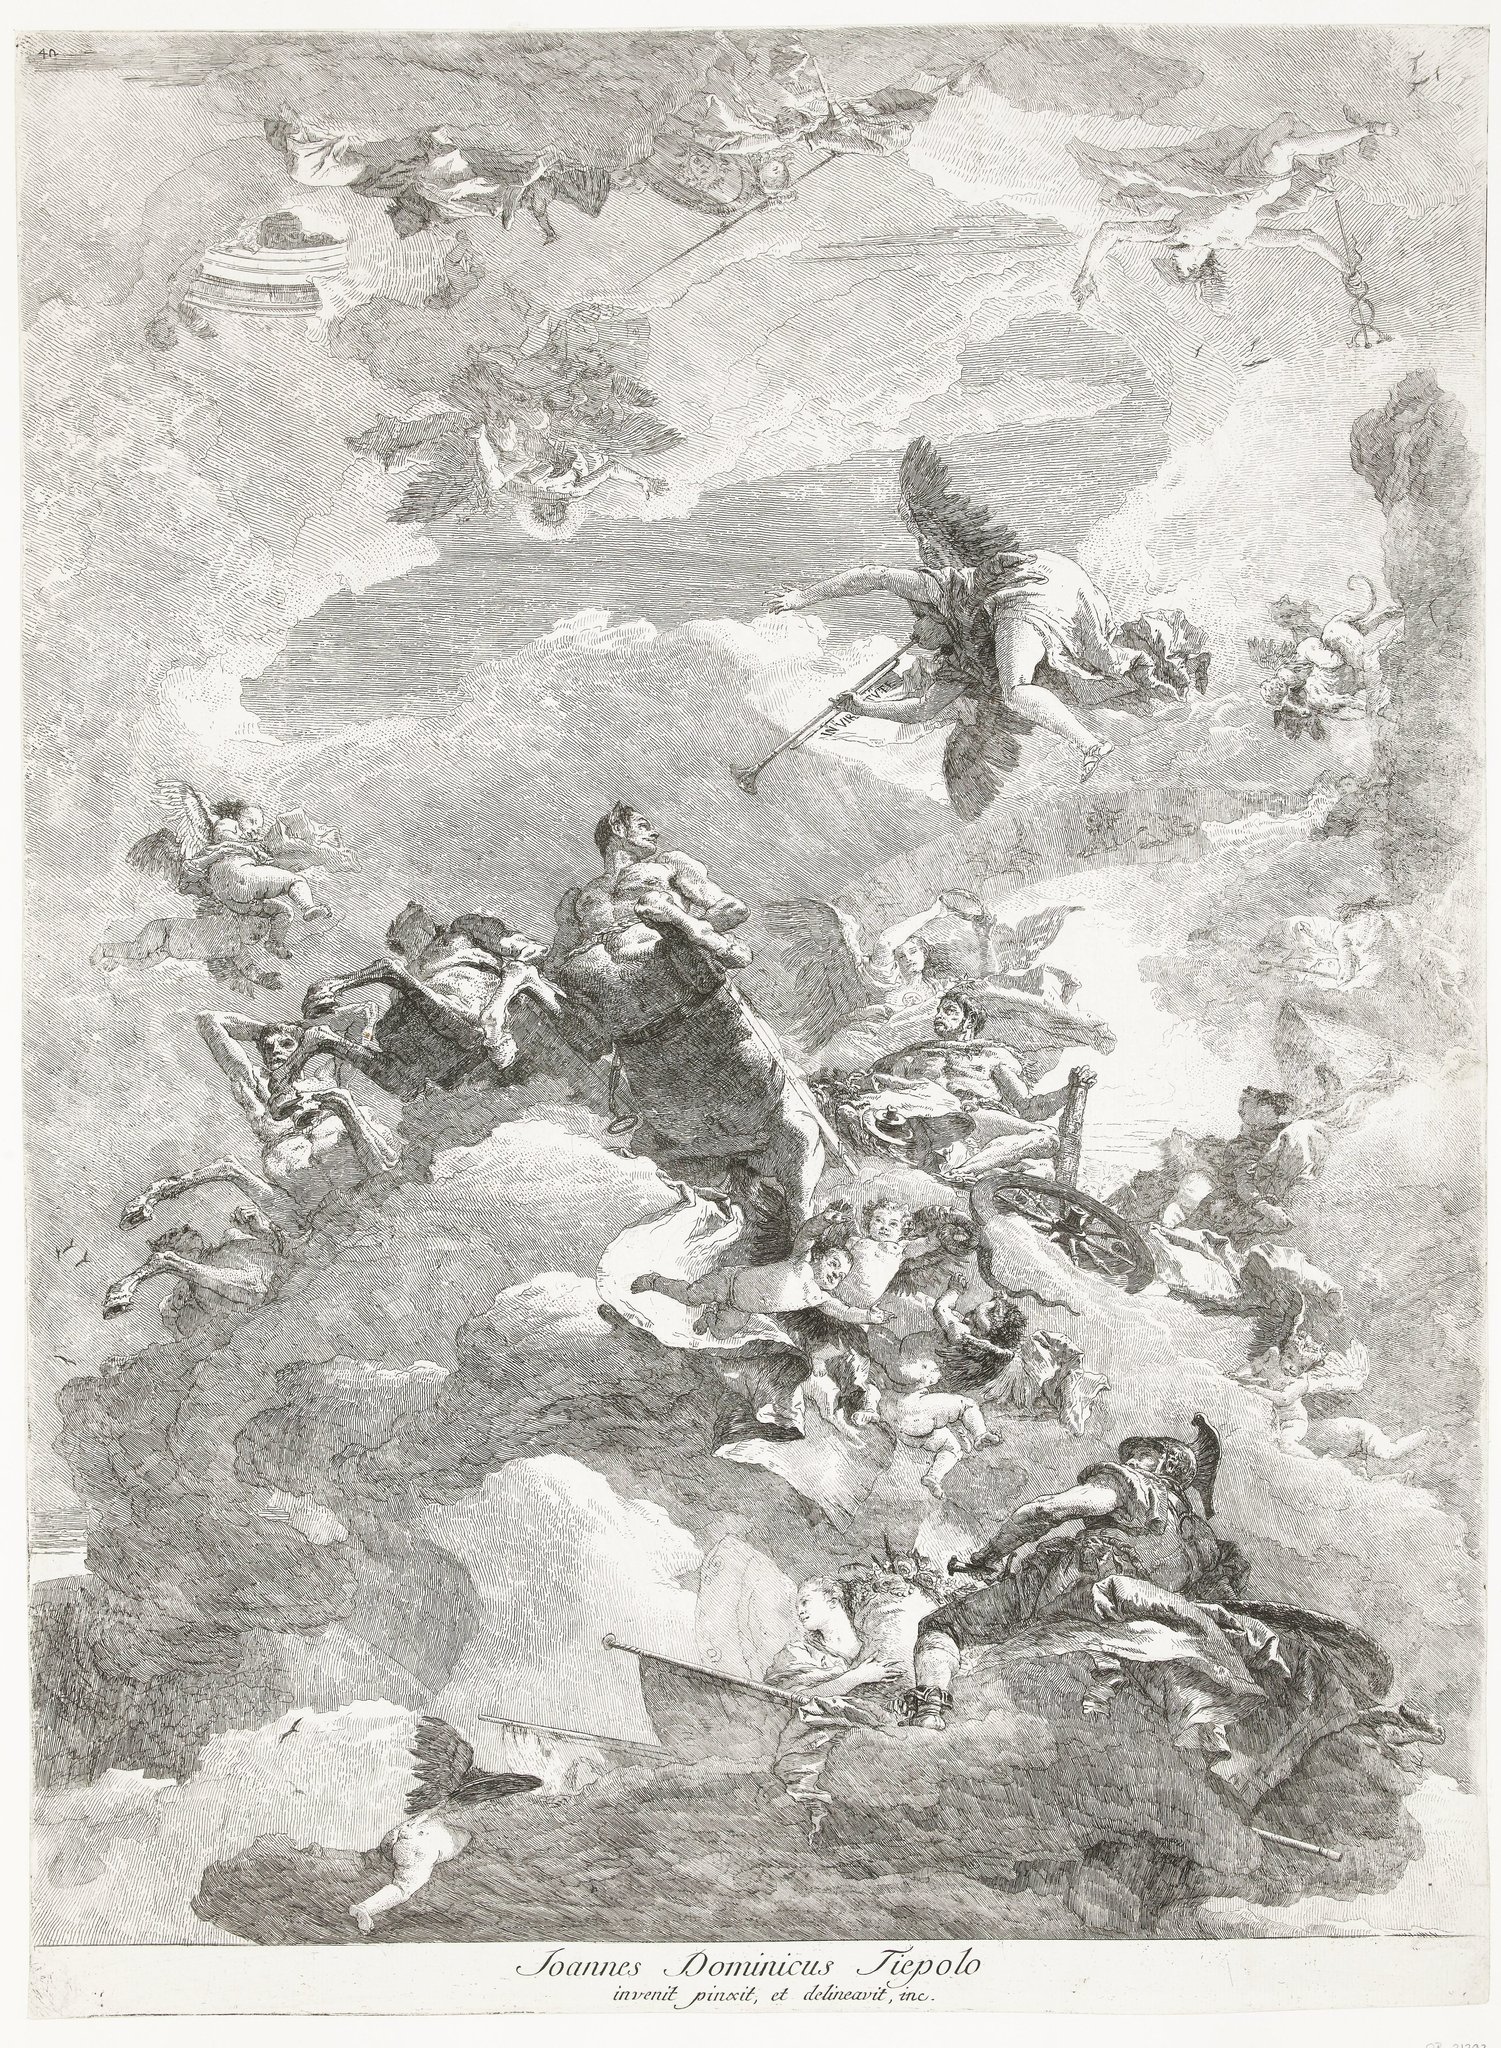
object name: print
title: Plafondschilderingen te Sint Petersburg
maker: giovanni domenico tiepolo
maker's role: draughtsman, print maker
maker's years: 1727-1804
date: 1757-1761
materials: paper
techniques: etching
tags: specific aspects, allegorical aspects of hercules; hercules as patron - triumph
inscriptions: collector's mark: Lugt 2228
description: Prent naar plafondschildering te Sint Petersburg door Giovanni Domenico Tiepolo zelf. Prent uit serie van vier prenten naar deze plafondschilderingen, de overige drie zijn in prent gebracht door Lorenzo Baldissera Tiepolo.